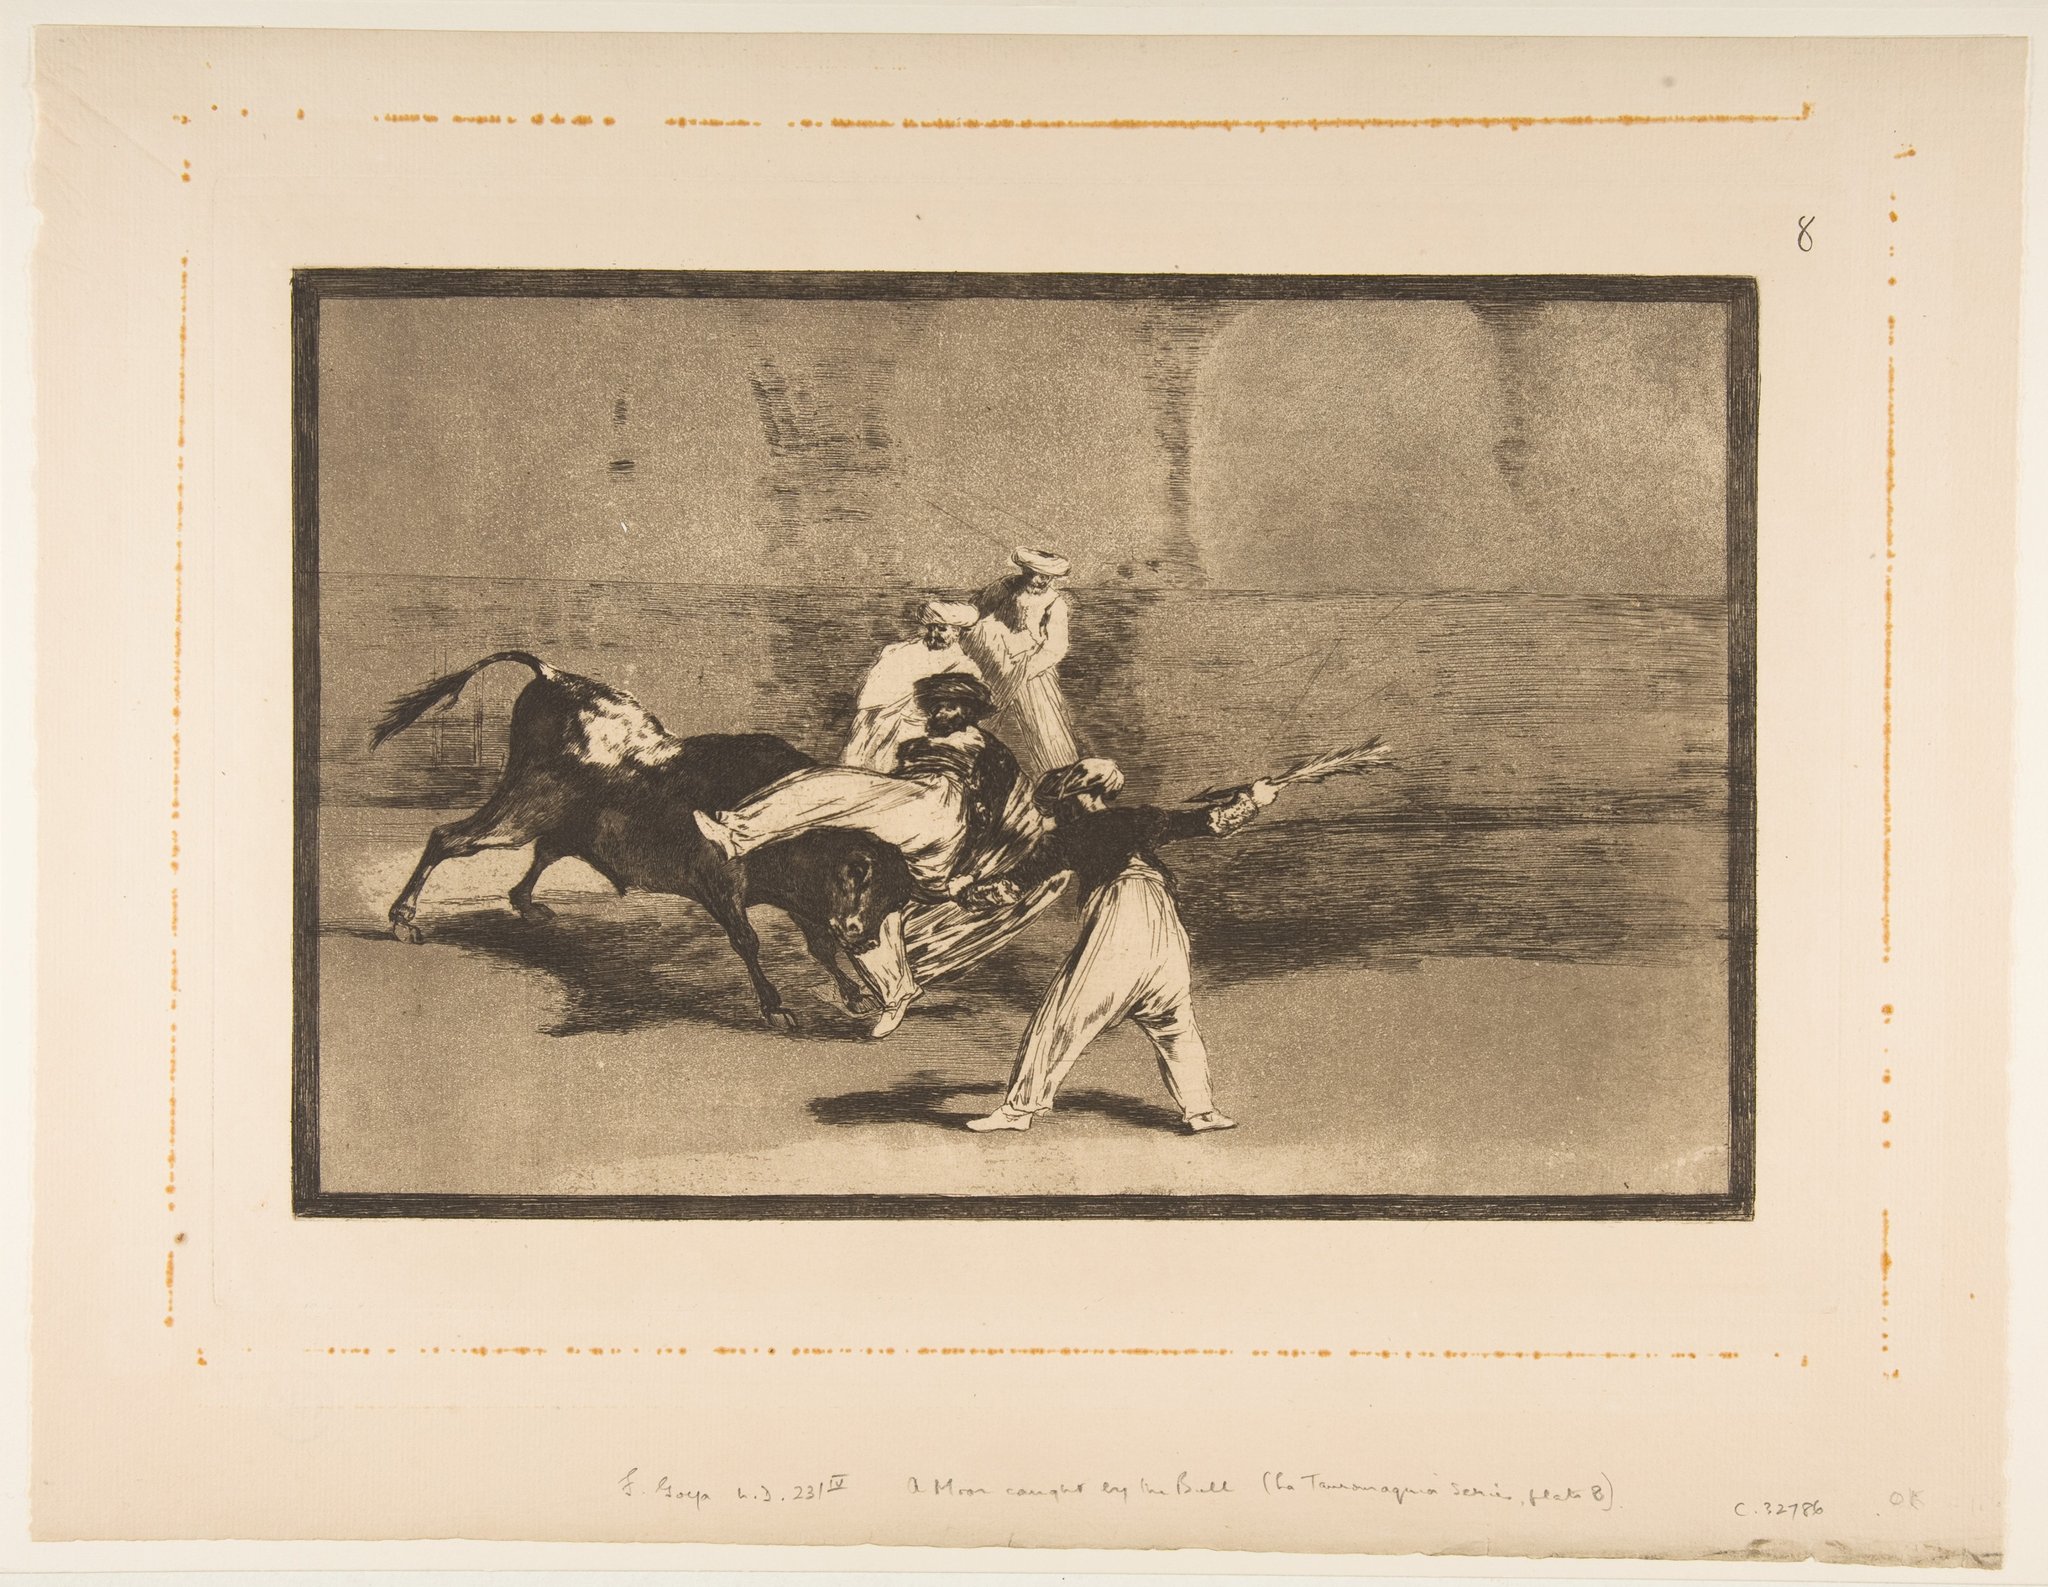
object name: print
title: Plate 8 from "Tauromaquia": A moor caught by the bull in the ring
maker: goya (francisco de goya y lucientes)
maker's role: artist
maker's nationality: spanish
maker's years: 1746-1828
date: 1816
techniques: aquatint, burnishing, drypoint, etching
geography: spain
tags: men,bulls